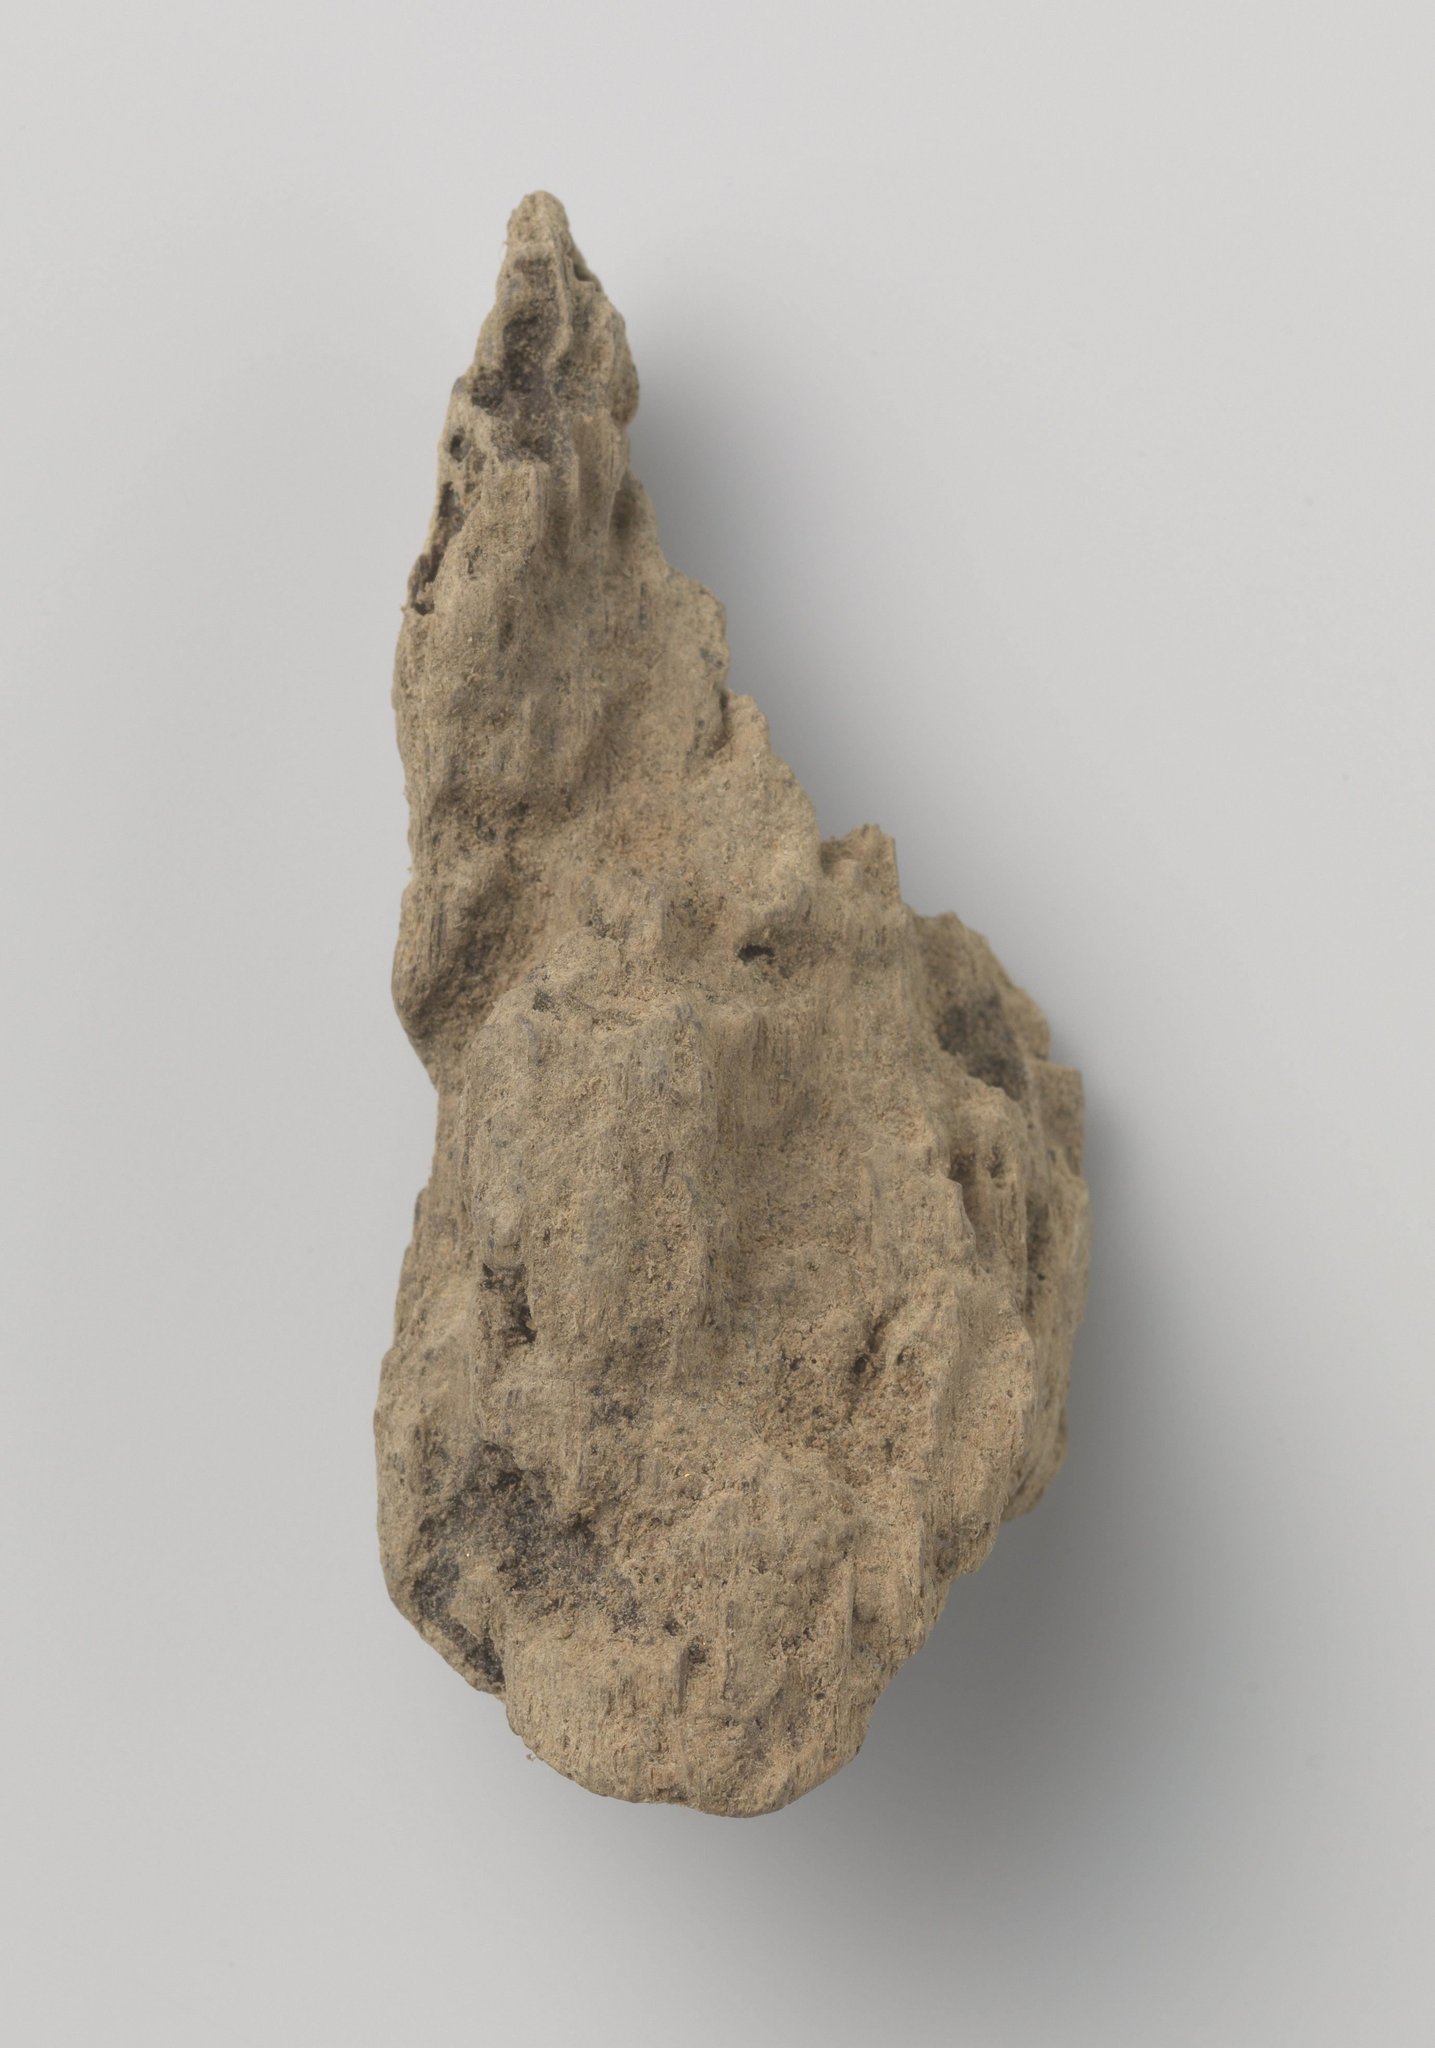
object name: fragment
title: Fragment; (mogelijk) behorend tot het retabel van Soest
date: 1475-1499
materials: wood